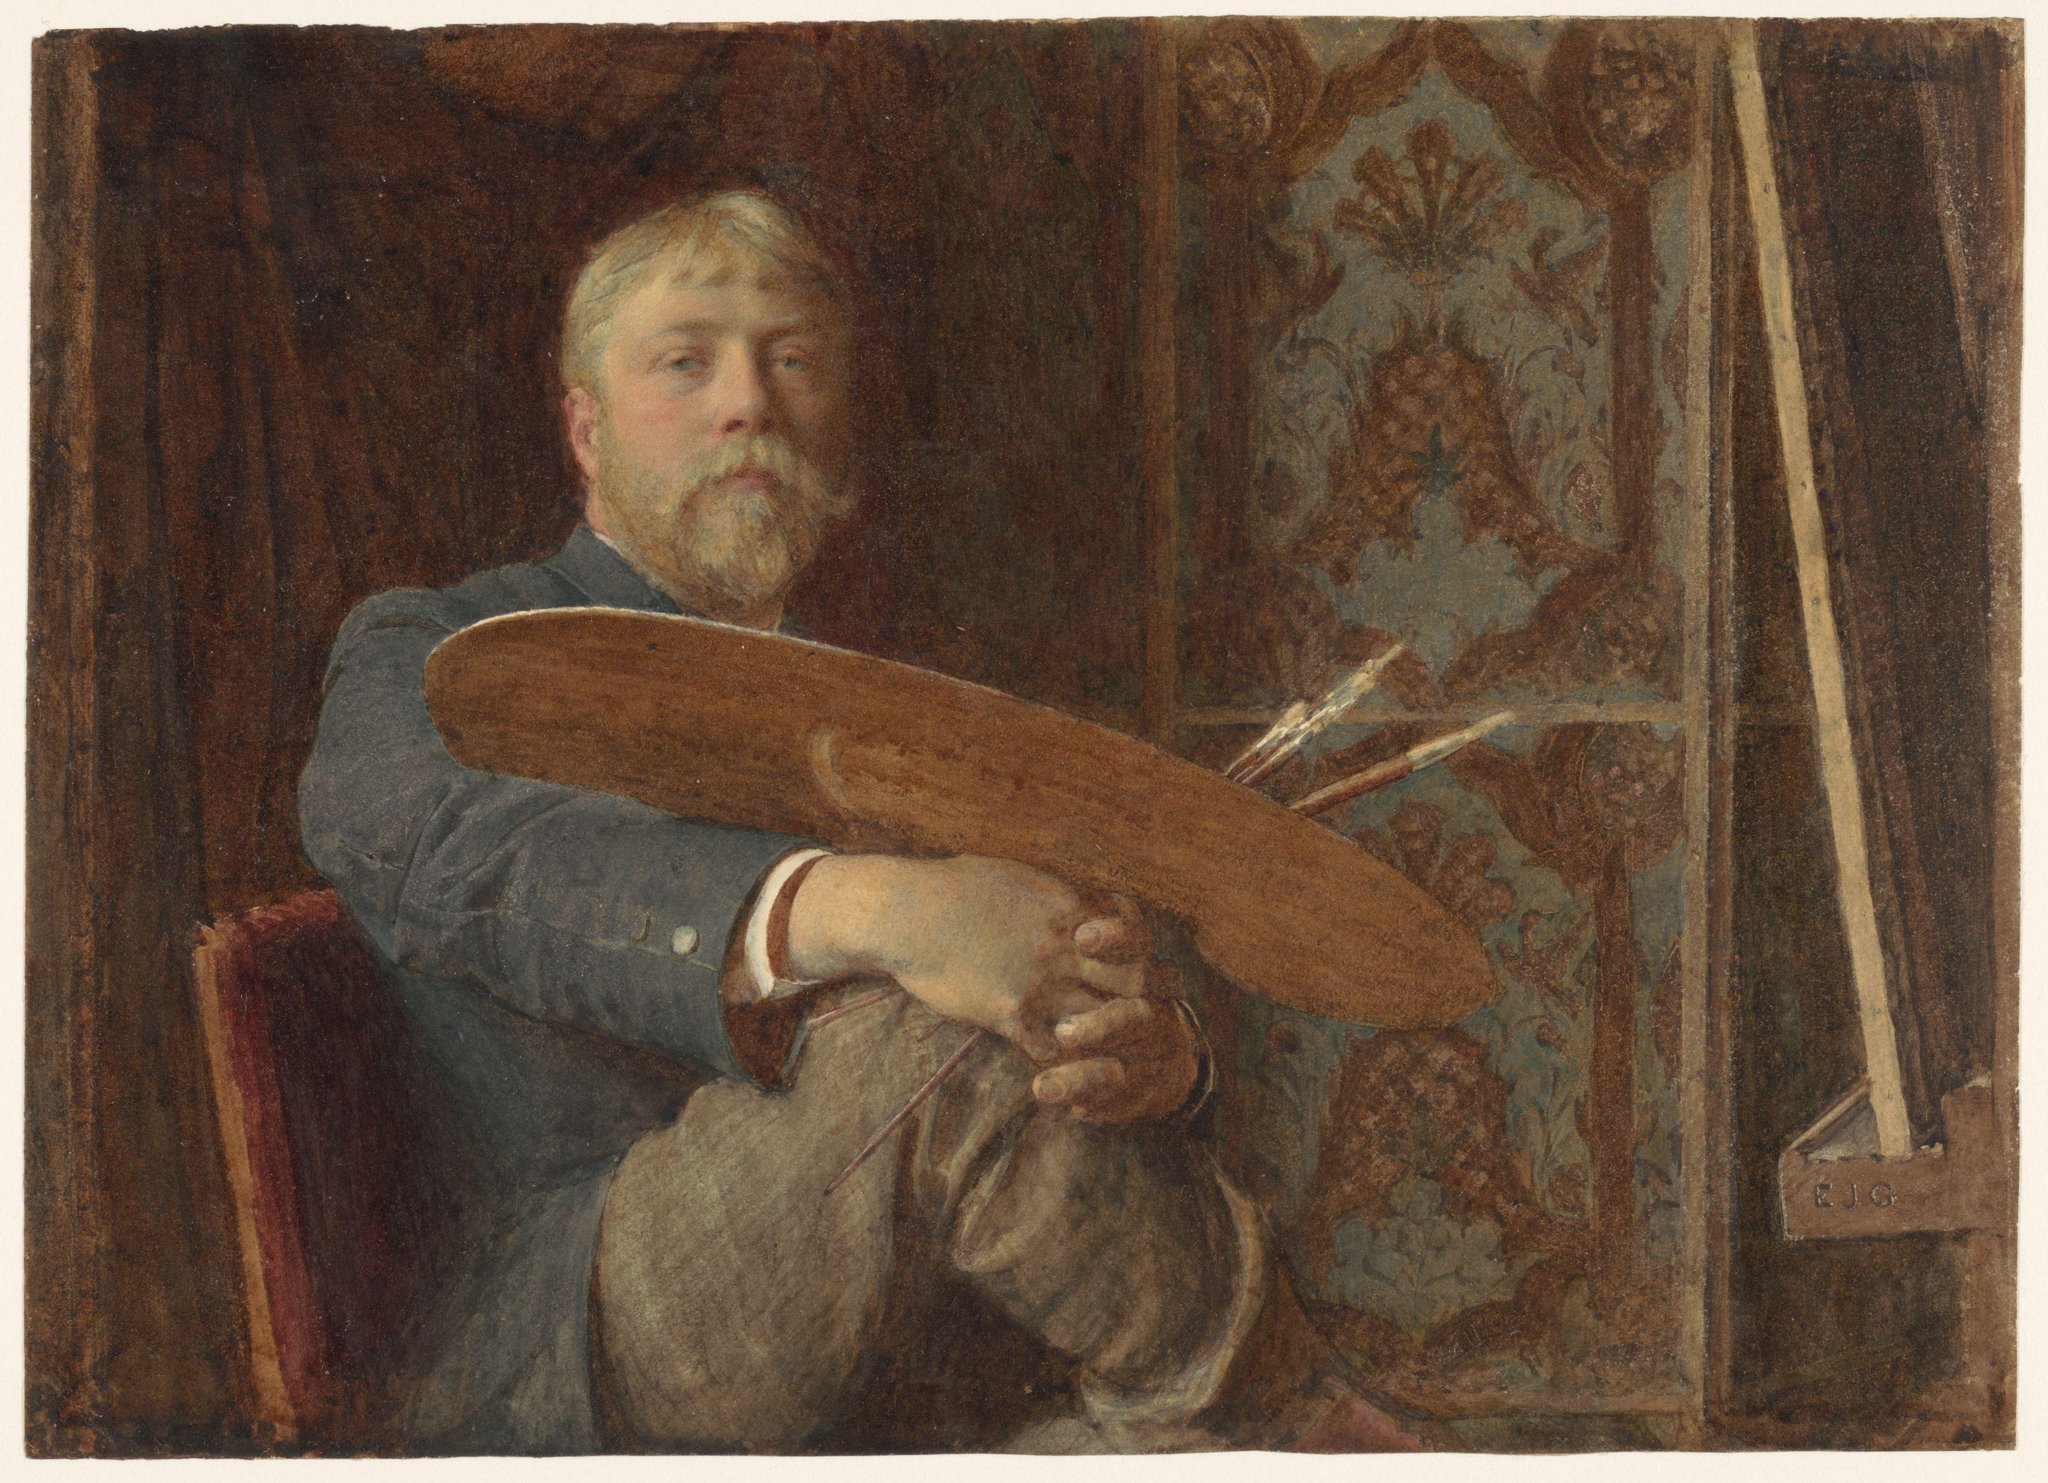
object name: drawing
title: Zelfportret van Edward John Gregory, met palet en penselen, zittend voor de ezel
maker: edward john gregory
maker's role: draughtsman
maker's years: 1850-1909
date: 1870-1909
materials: paint, gouache, paper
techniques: brush, varnishing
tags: draughtsman, edward john gregory, portrait, self-portrait of painter, portrait, self-portrait of artist